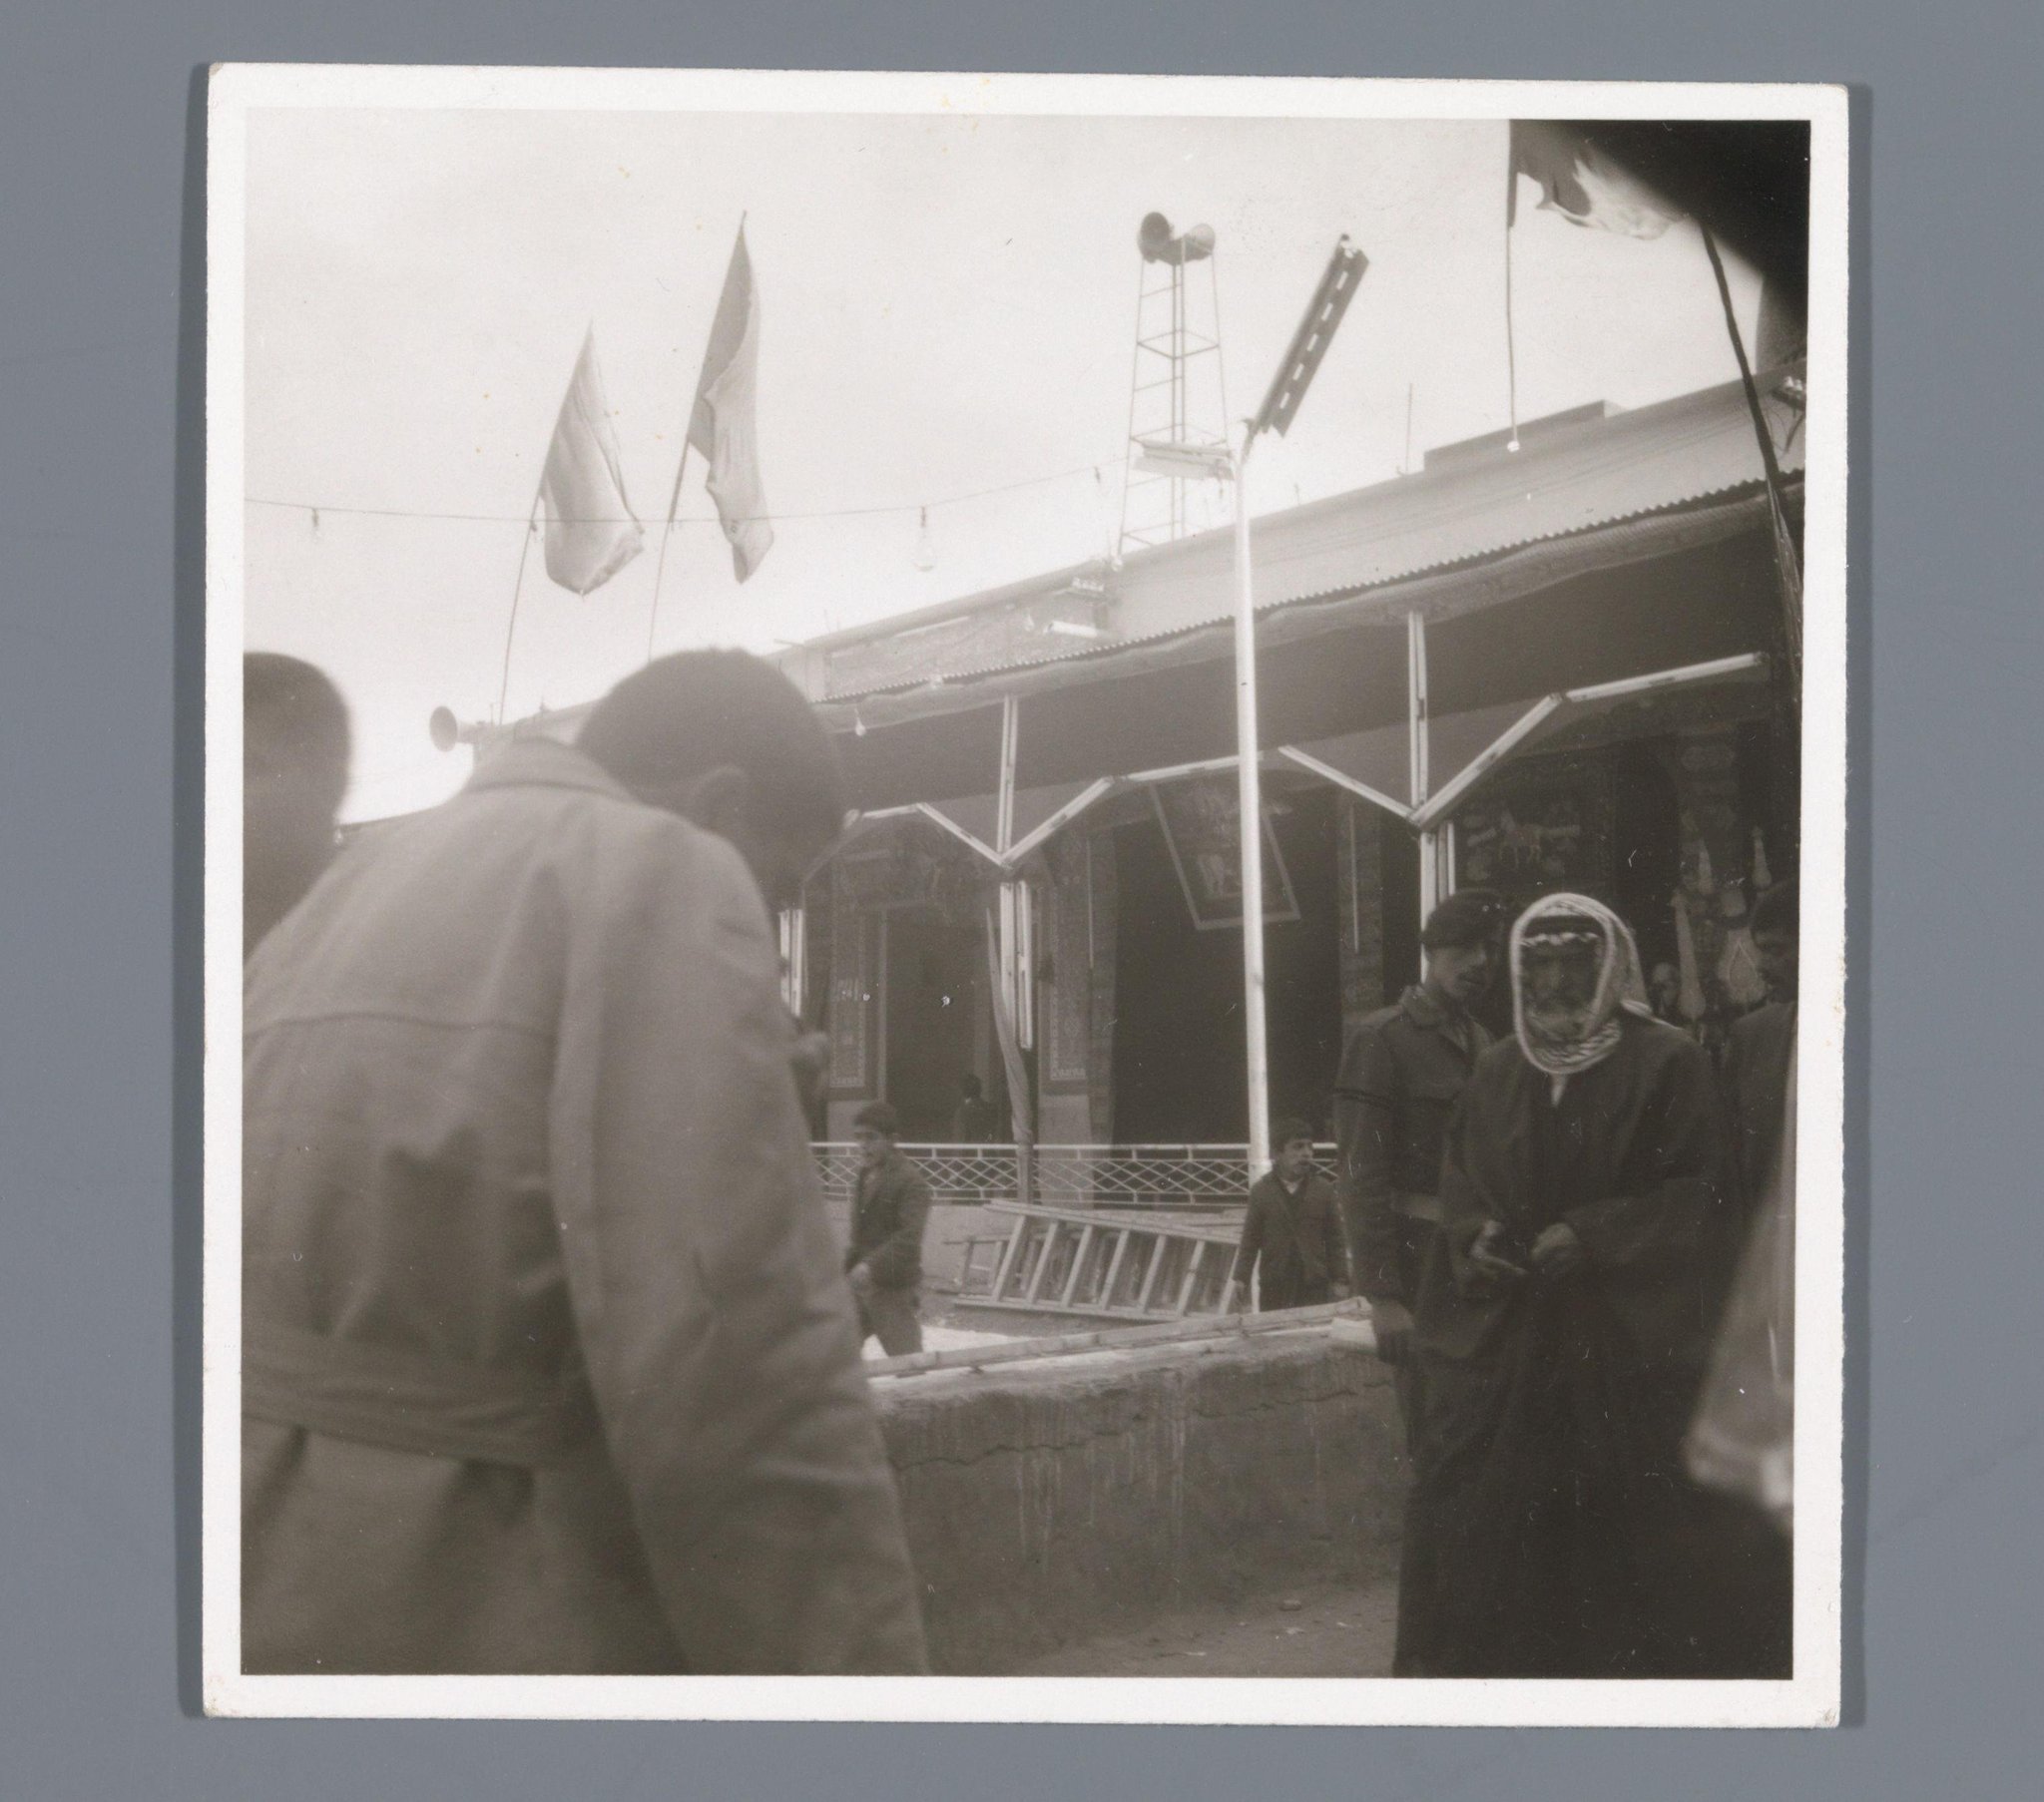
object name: photograph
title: Straatgezicht in Bagdad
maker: Anonymous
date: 1950-1970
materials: photographic support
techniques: gelatin silver print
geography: baghdad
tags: adult man, street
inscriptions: inscription: ‘[Tekst in het Irakees]’